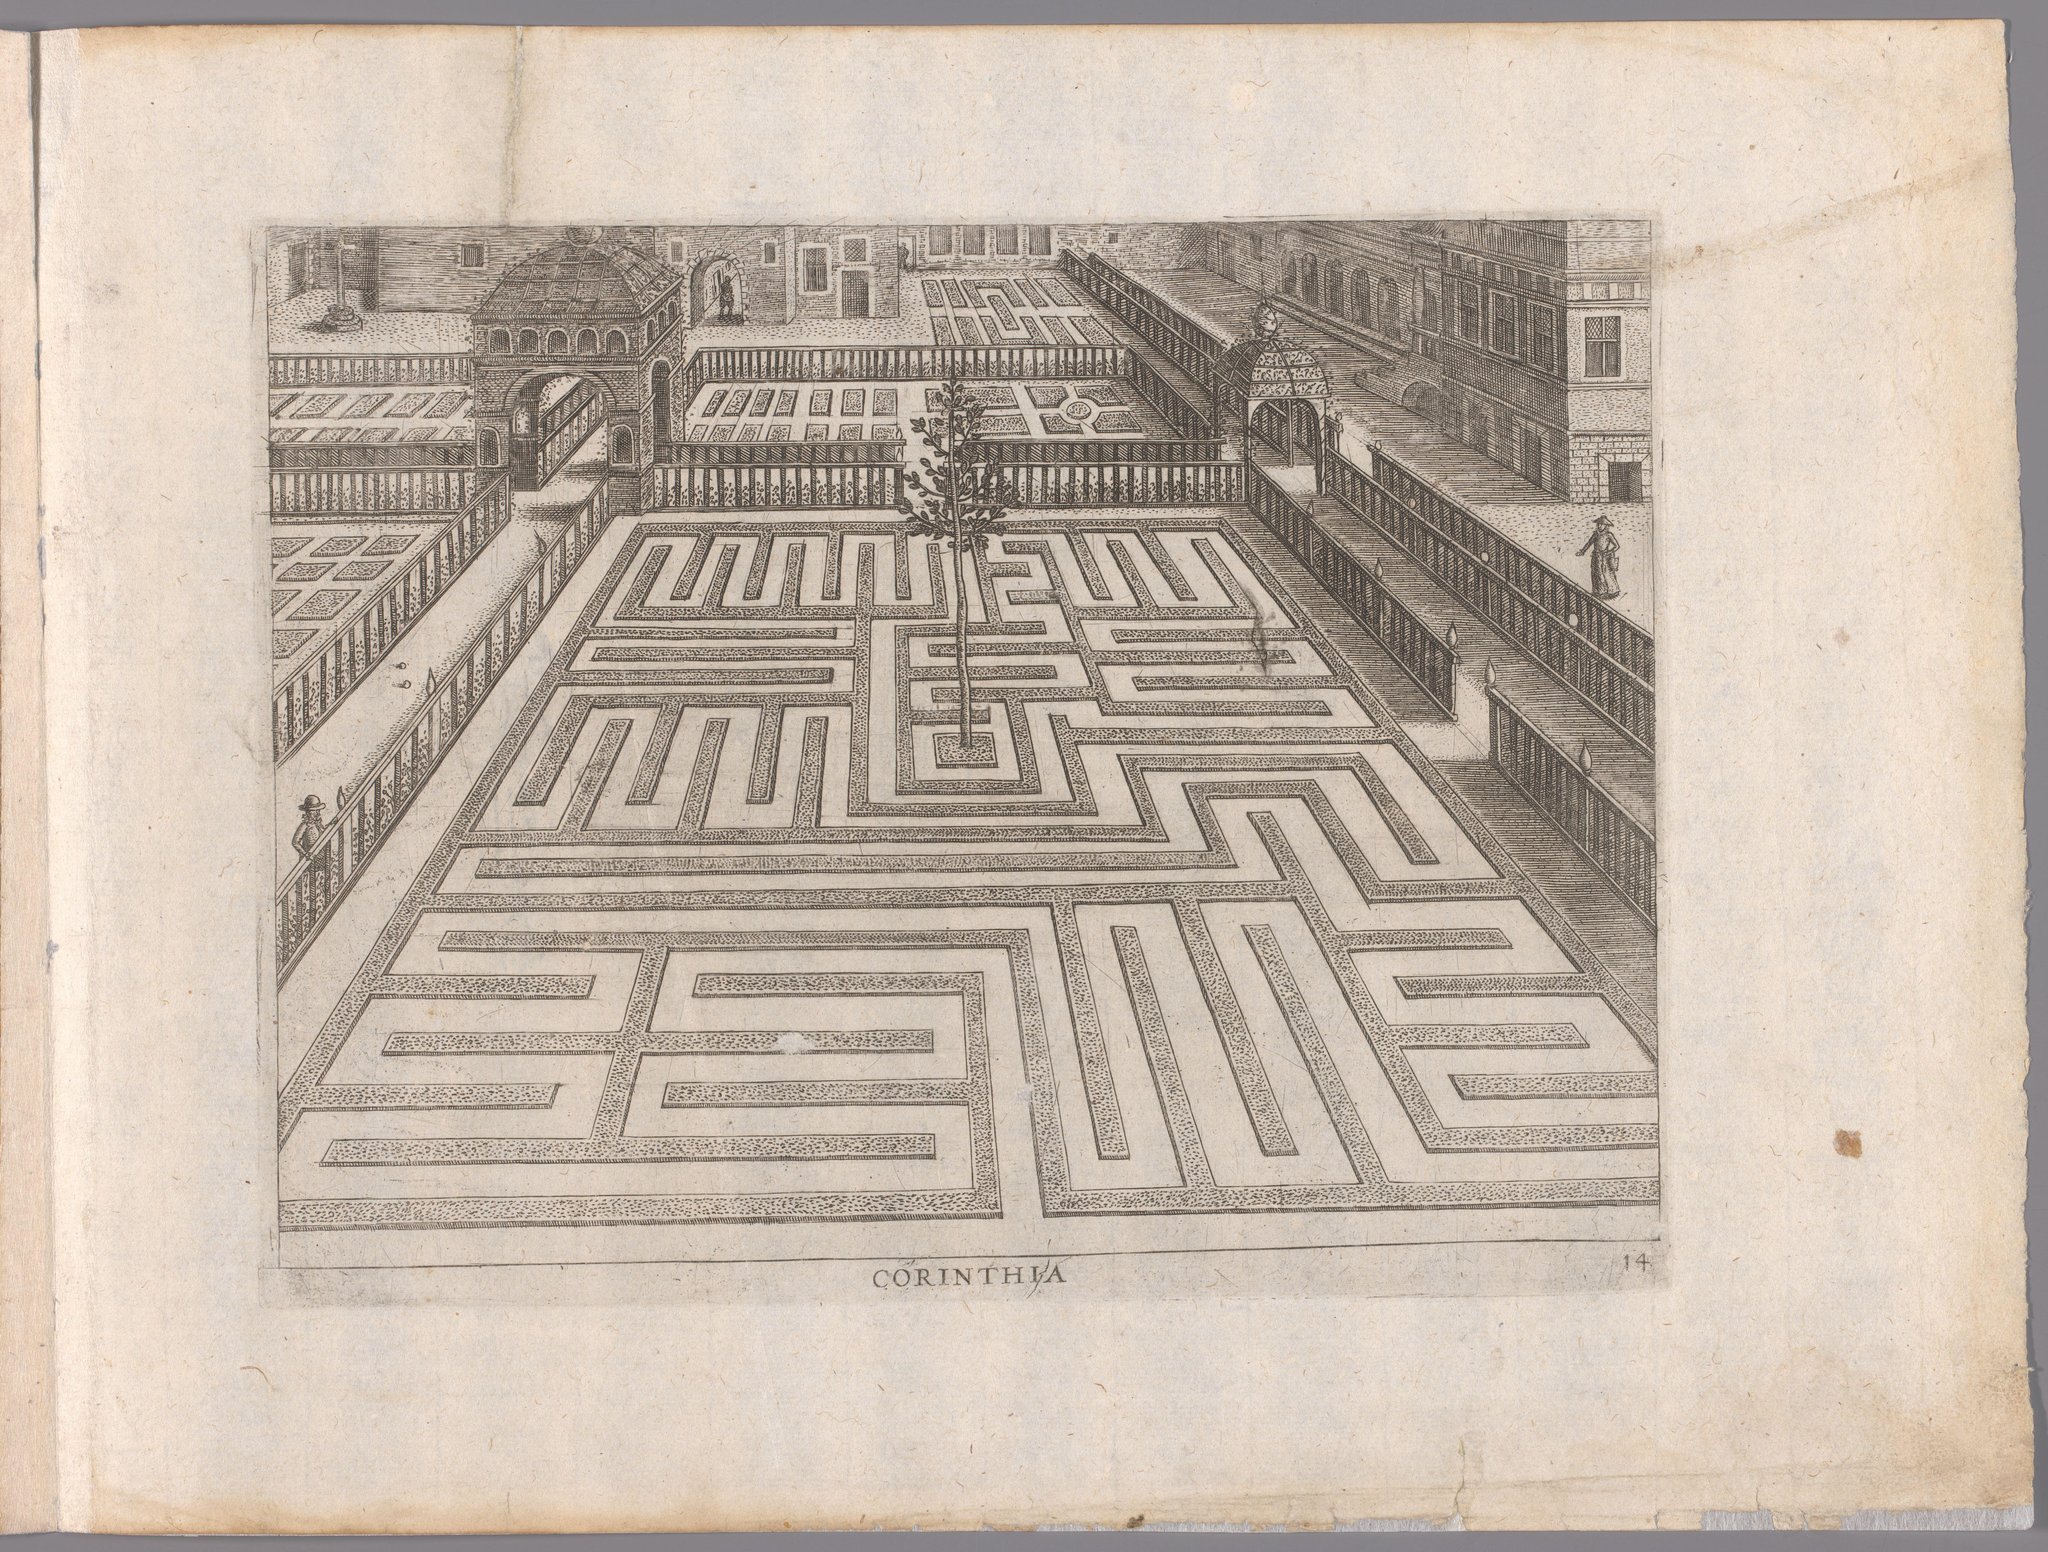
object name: print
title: Tuinontwerpen geassocieerd met de Dorische, Ionische en Korinthische bouworden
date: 1583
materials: paper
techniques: etching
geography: antwerp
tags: garden, french or architectonic garden; formal garden, labyrinth, maze ~ garden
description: Op de voorgrond staat een hoge boom in het midden van een rechthoekige parterre, omgeven door een balustrade. In het midden staat een boom. Links loopt een vrouw met een mand. De tuin is aangelegd volgens de Korinthische bouworde.